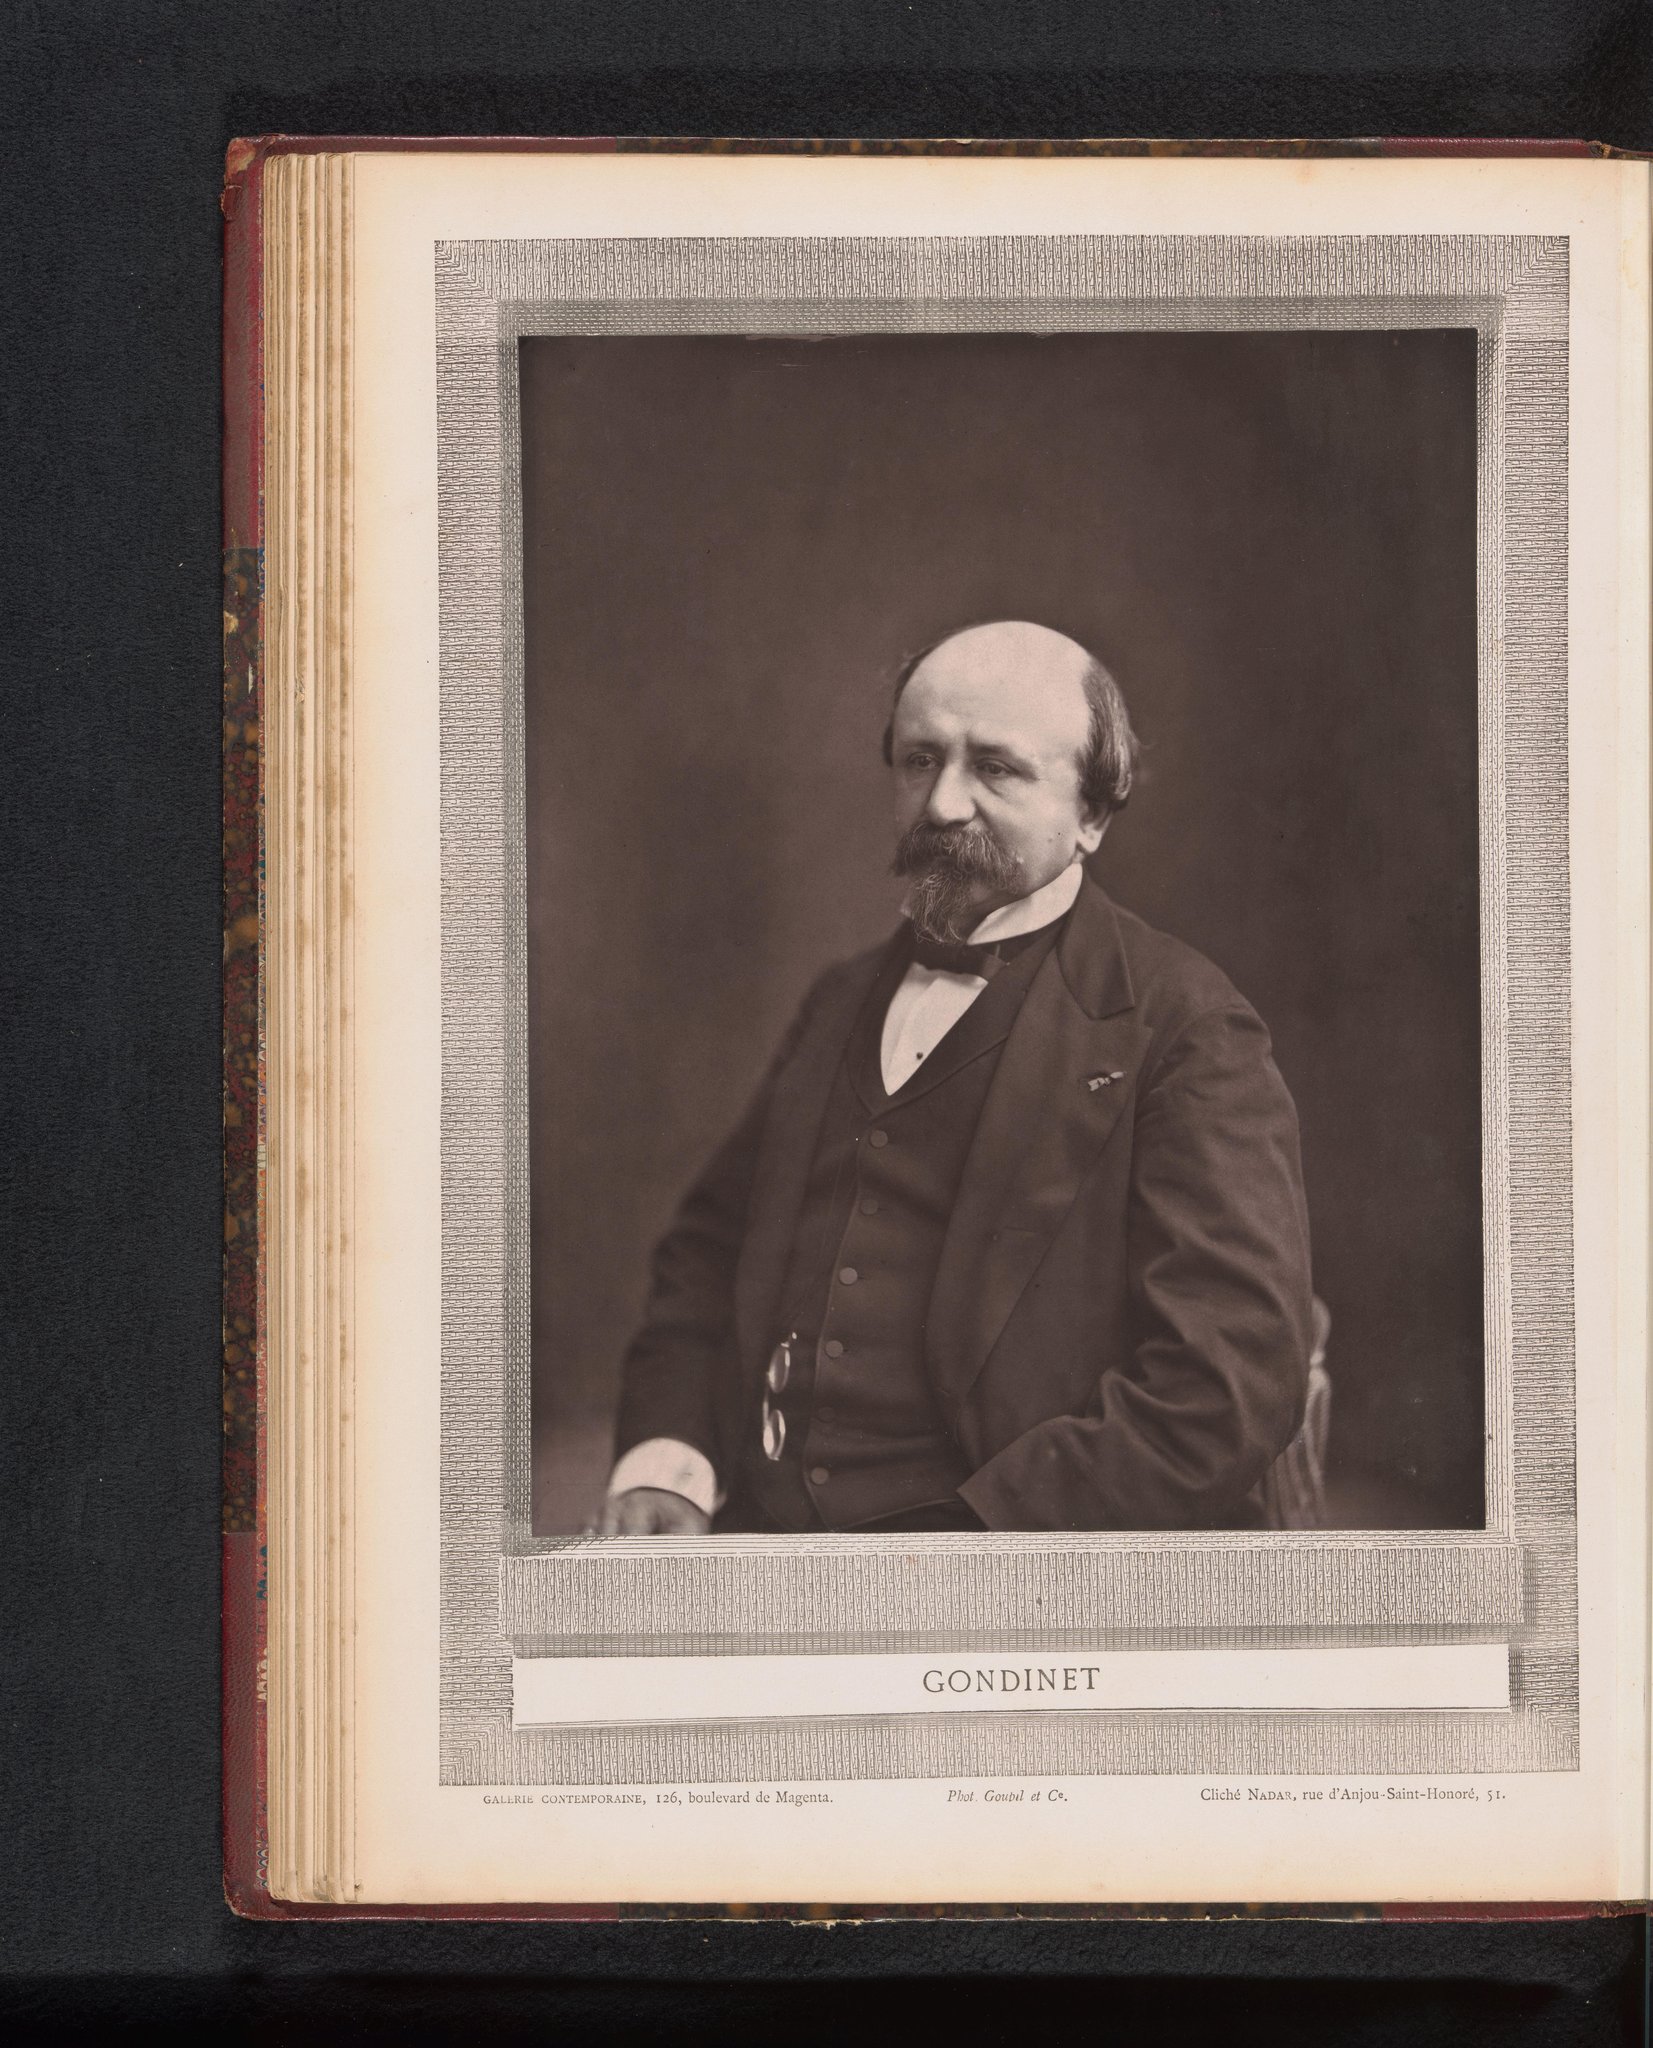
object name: page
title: Gondinet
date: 1872-1877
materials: paper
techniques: printing block, woodburytype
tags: adult man, historical persons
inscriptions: inscription: ‘Galerie Contemporaine, 126, boulevard de Magenta.’